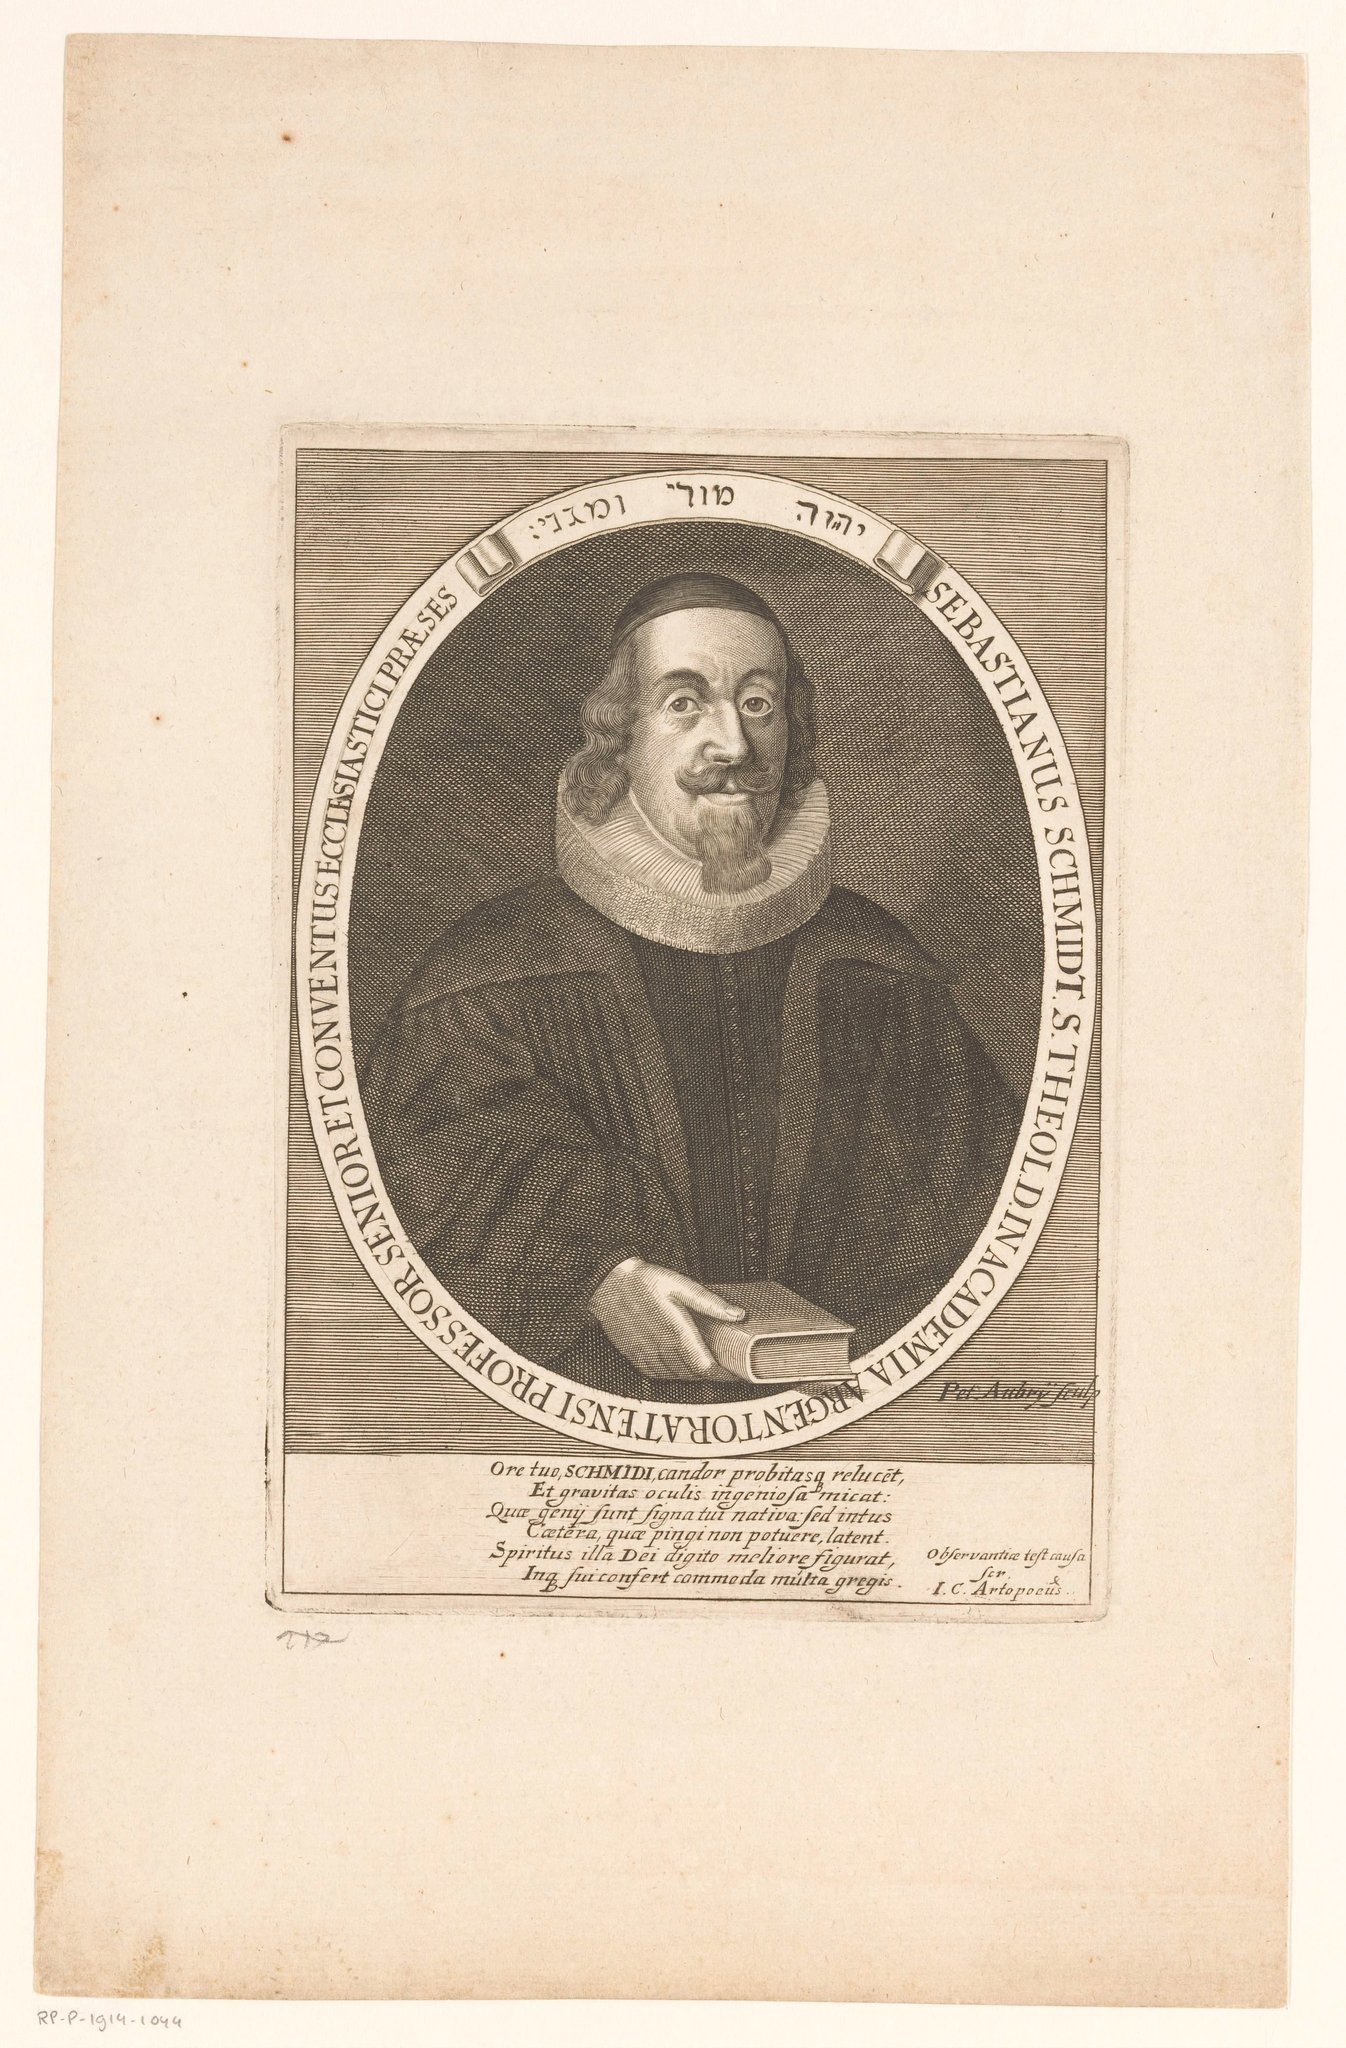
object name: print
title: Portret van Sebastian Schmidt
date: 1620-1686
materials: paper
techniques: engraving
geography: straatsburg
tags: historical persons, book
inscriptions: collector's mark: Lugt 2228